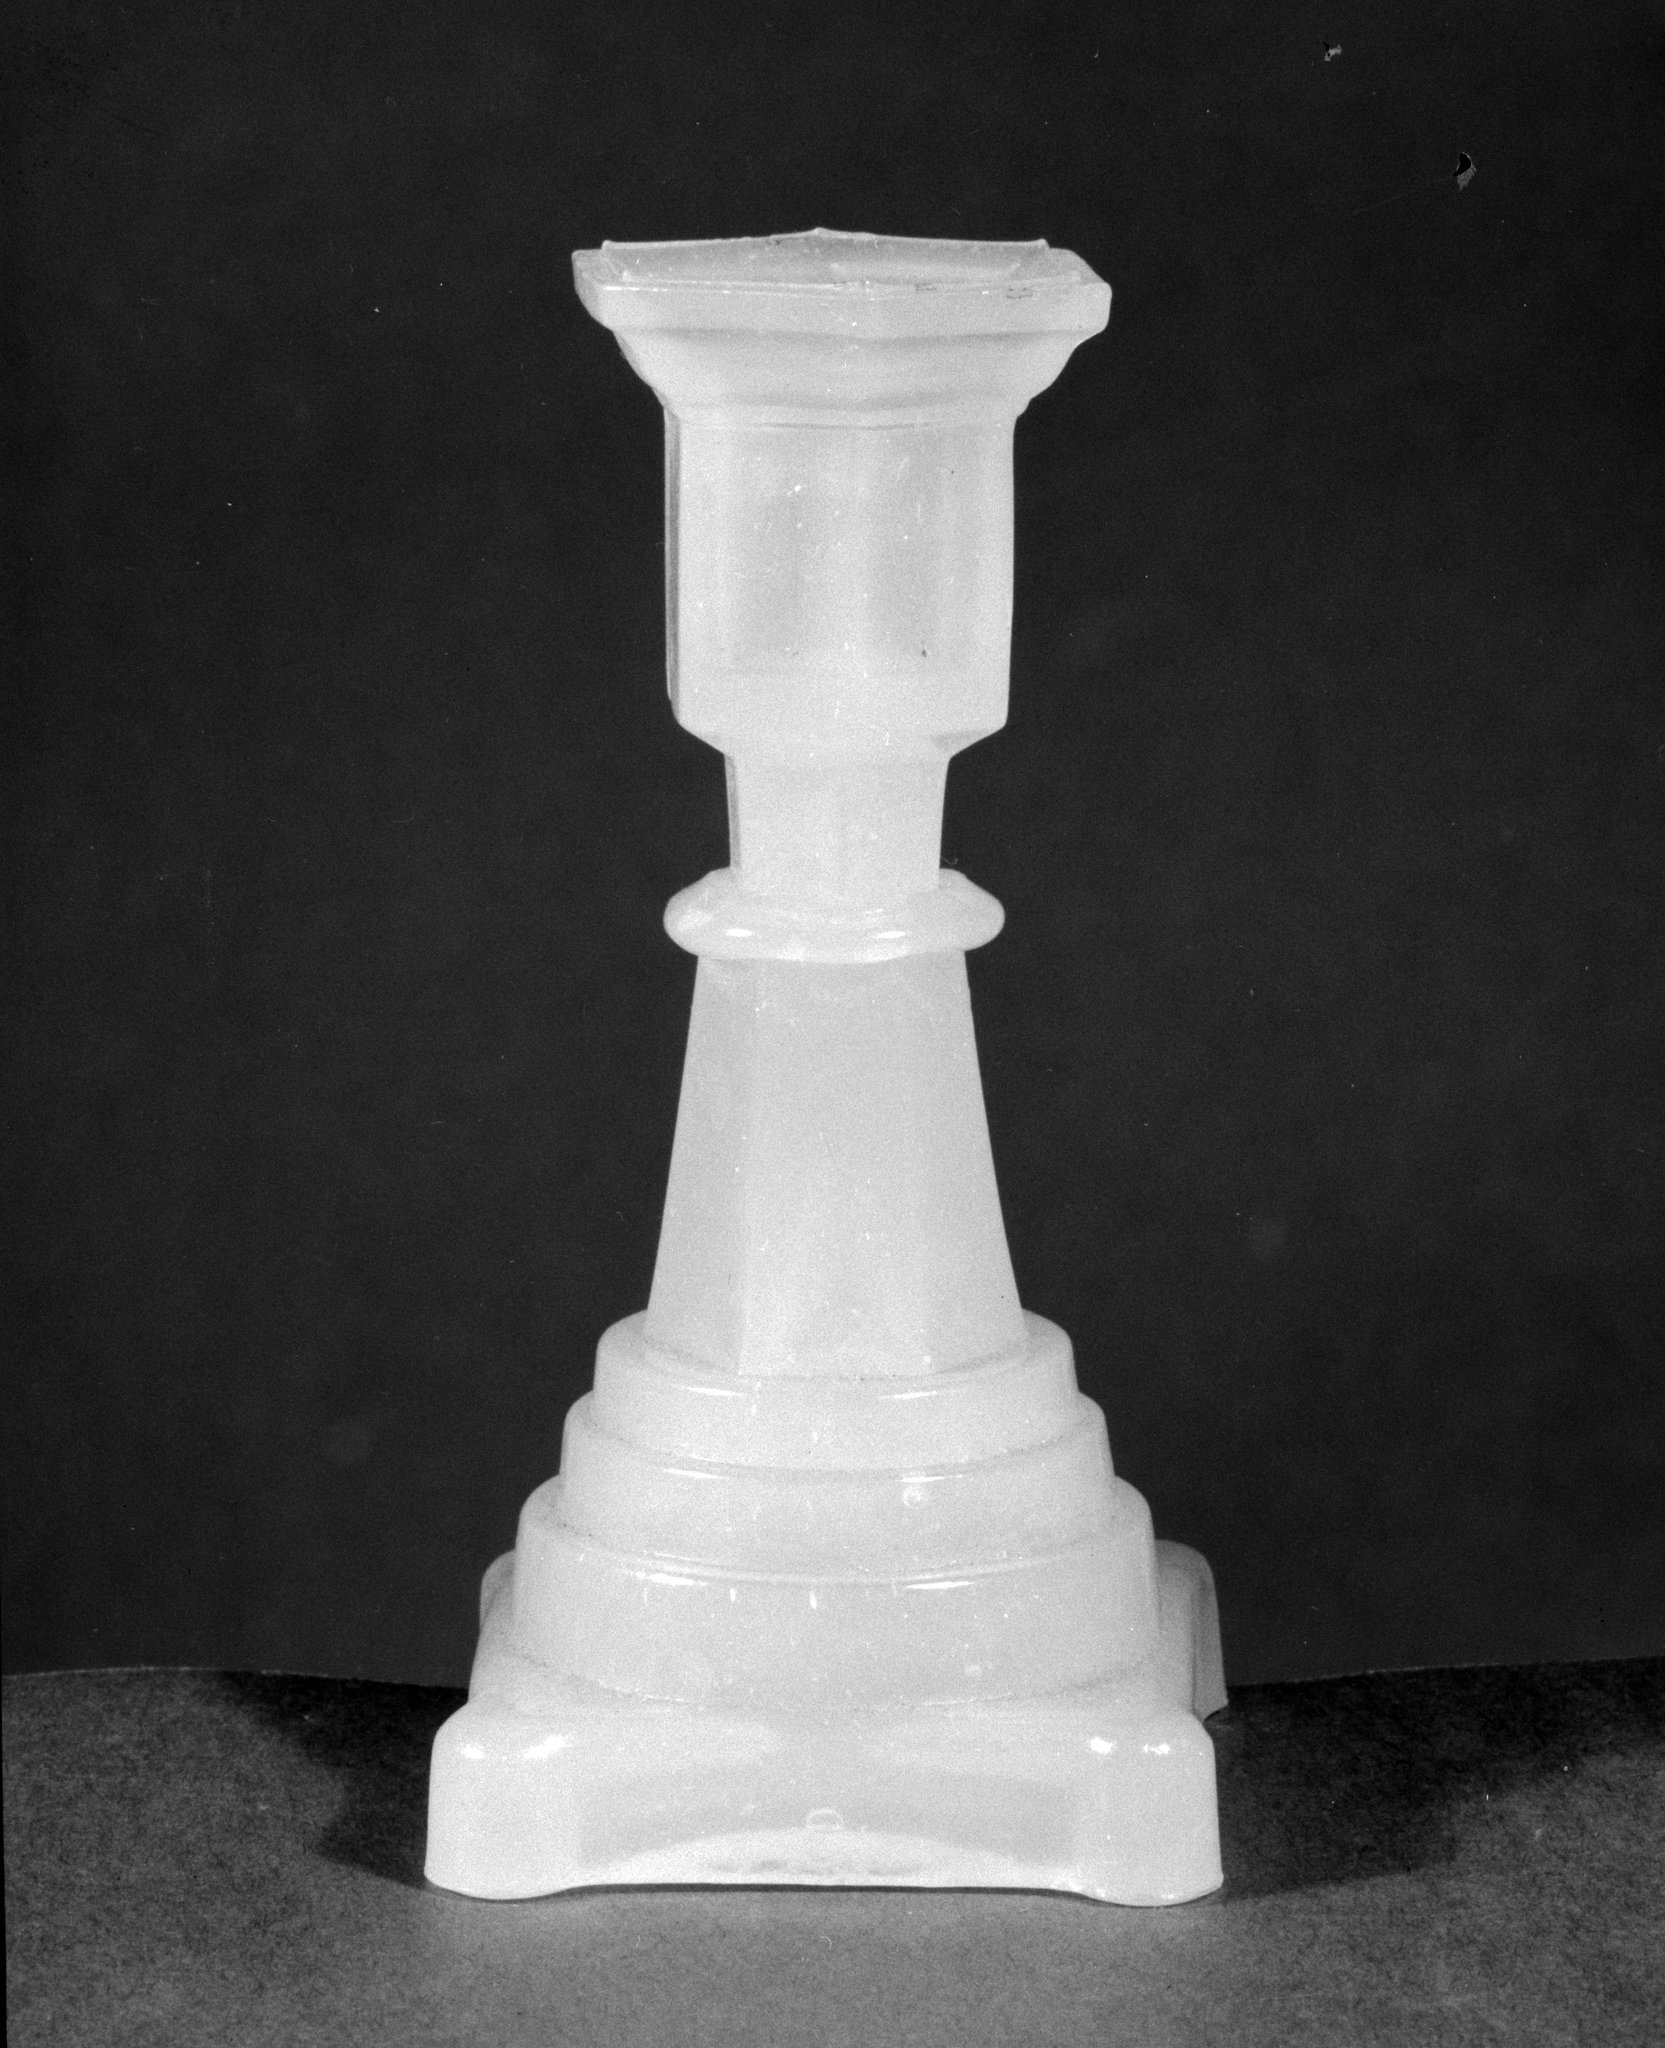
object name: candlestick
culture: american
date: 1840-1860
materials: glass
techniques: pressed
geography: united states